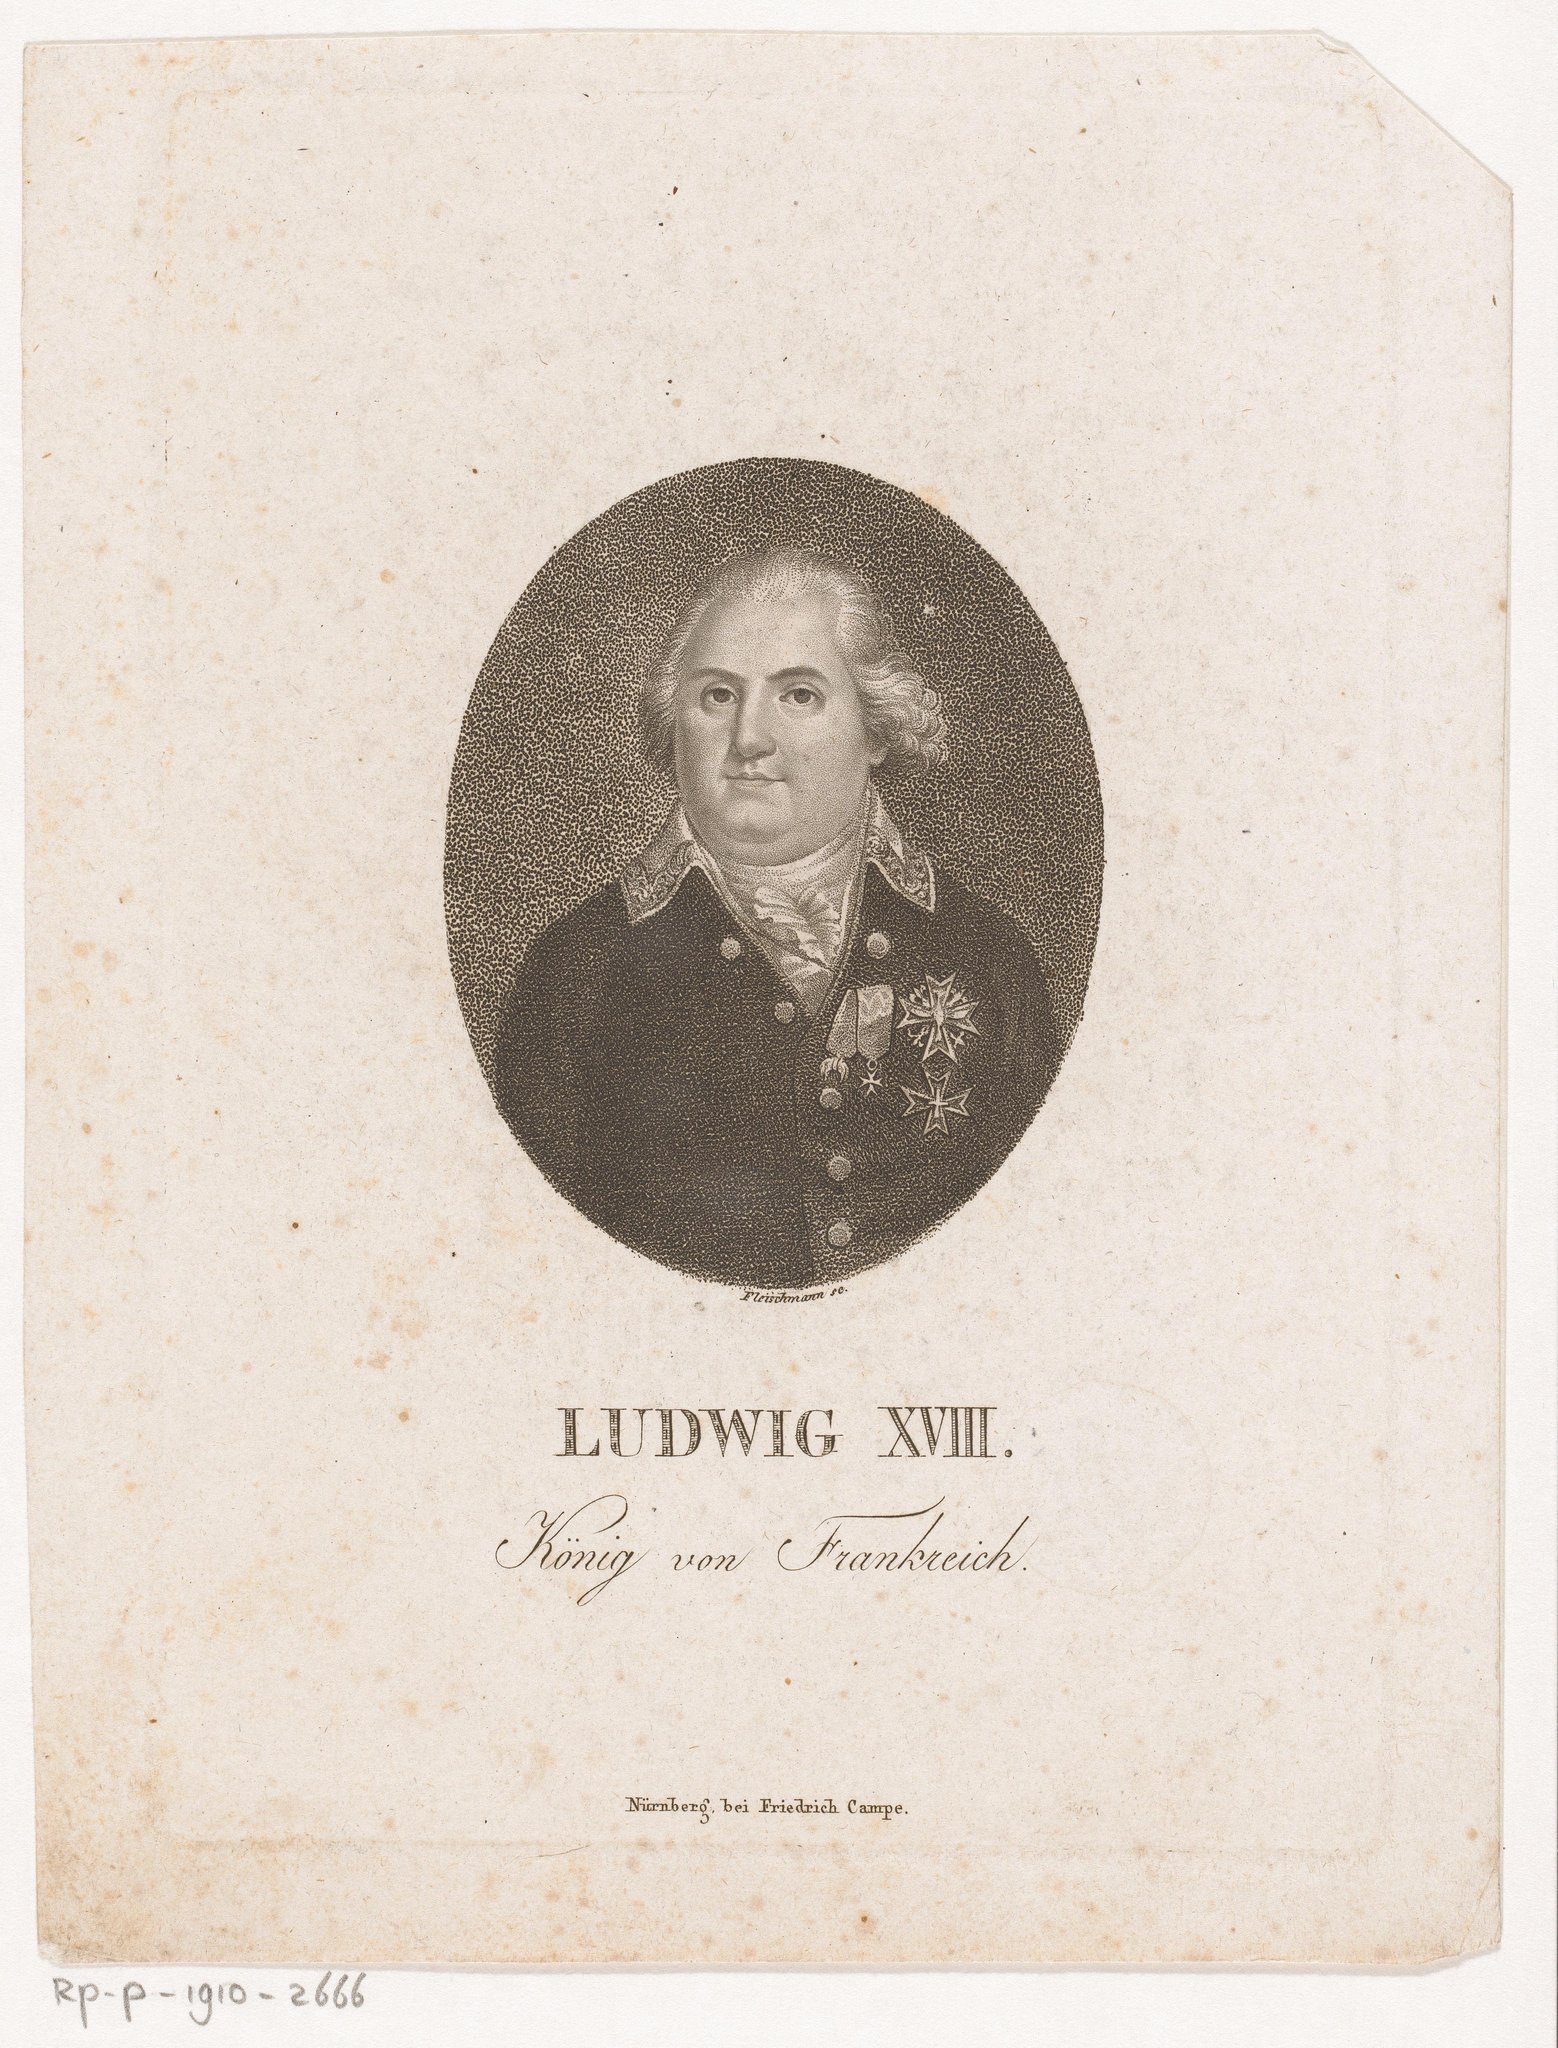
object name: print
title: Portret van Lodewijk XVIII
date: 1801-1834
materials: paper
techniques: stippling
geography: nuremberg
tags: paris, lodewijk xviii (koning van frankrijk), knighthood order, historical persons, ruler, sovereign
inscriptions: collector's mark: Lugt 2228